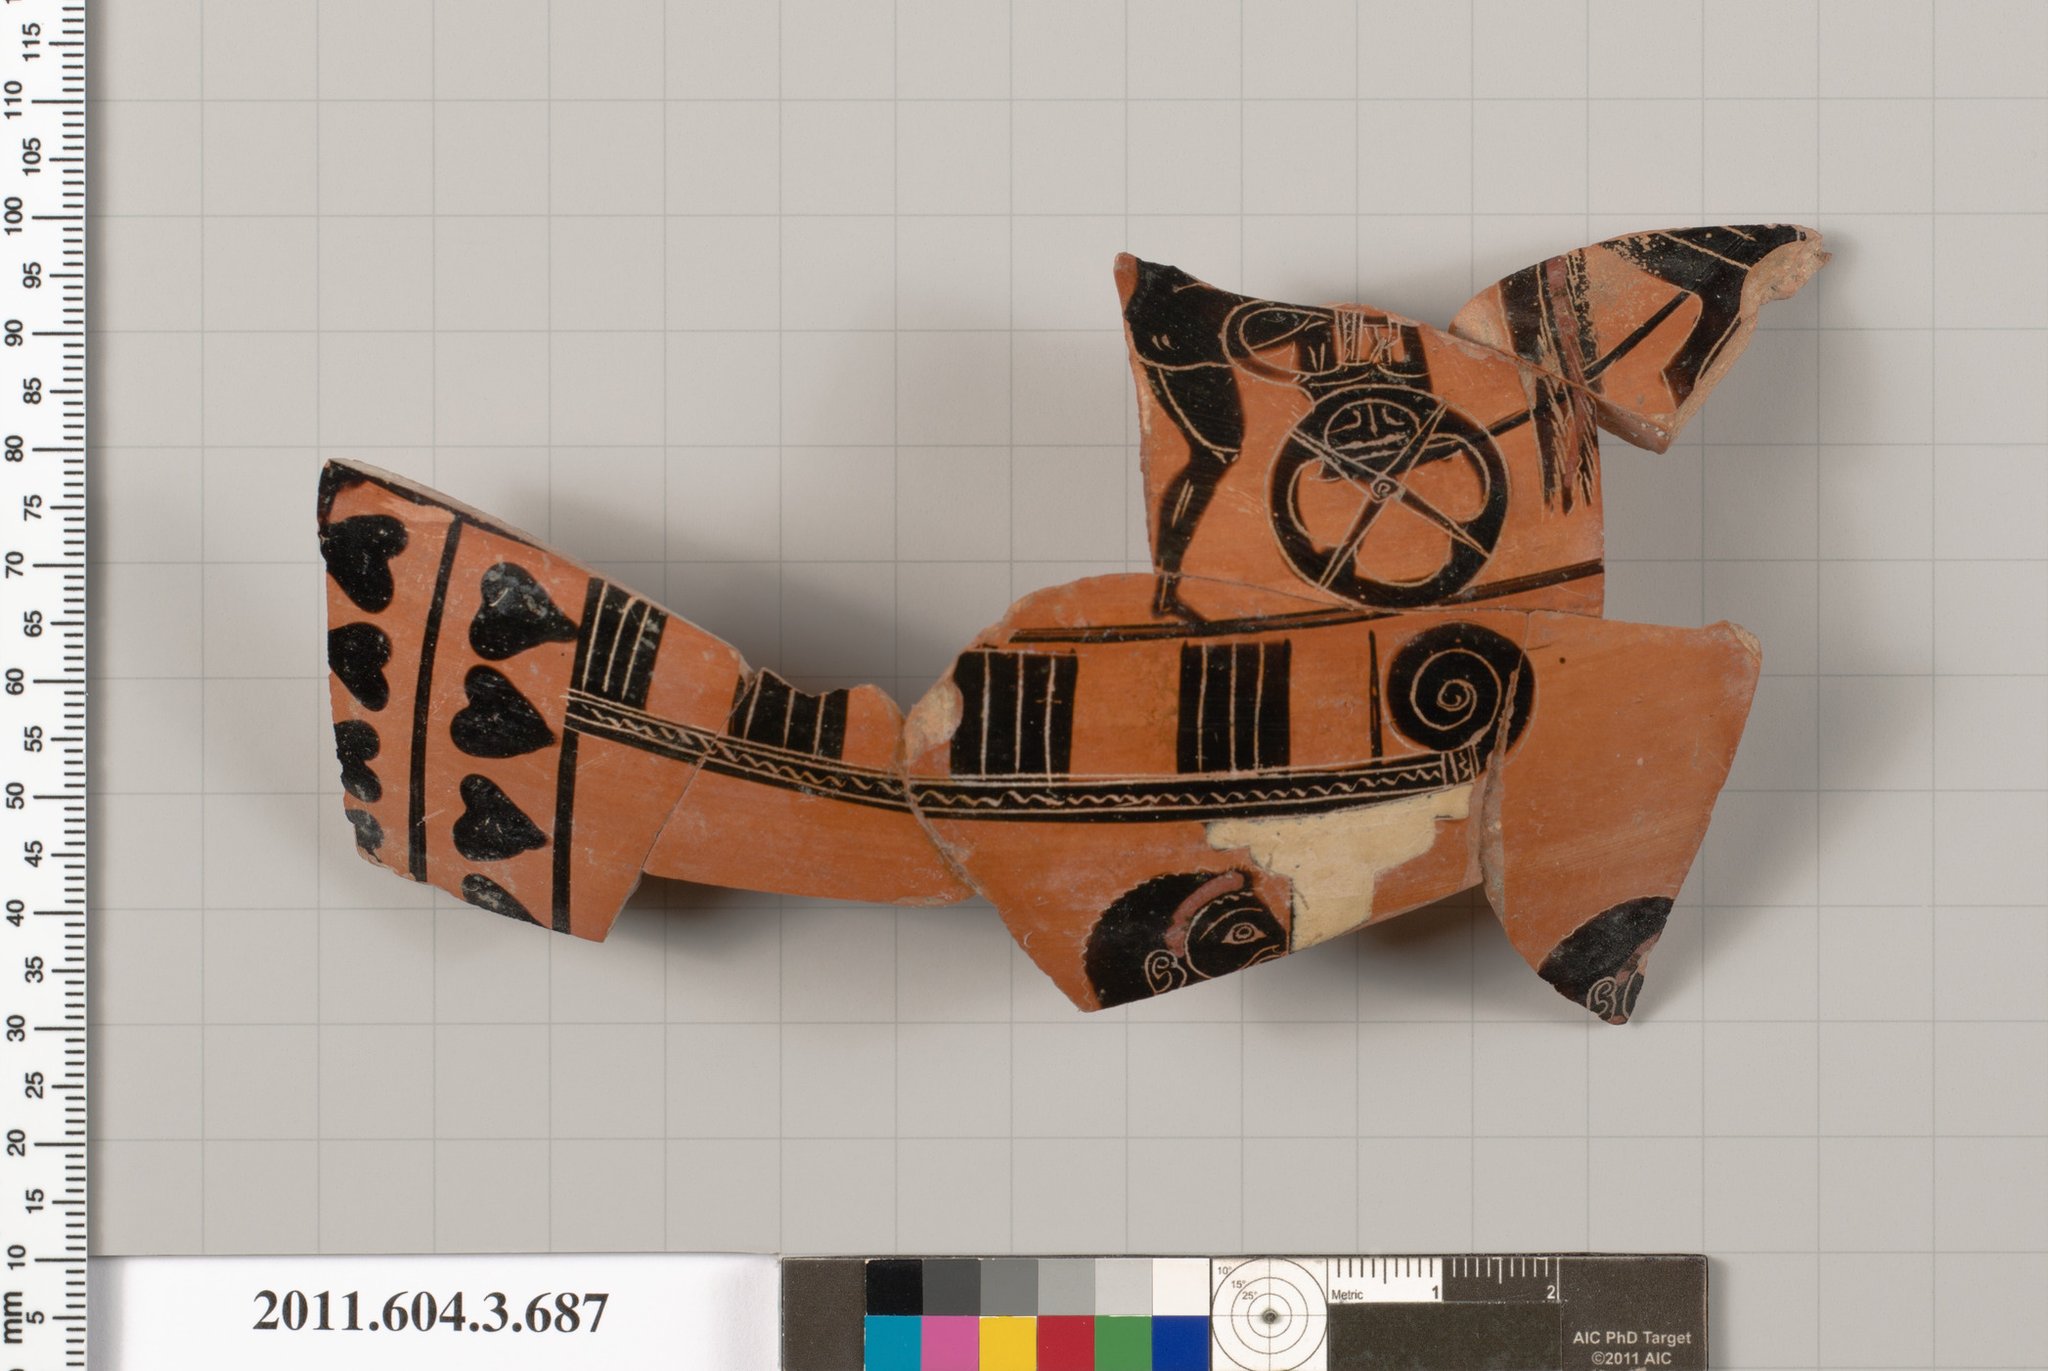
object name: hydria fragment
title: Terracotta fragment of a hydria (water jar)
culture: greek, attic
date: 550-526 BCE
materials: terracotta